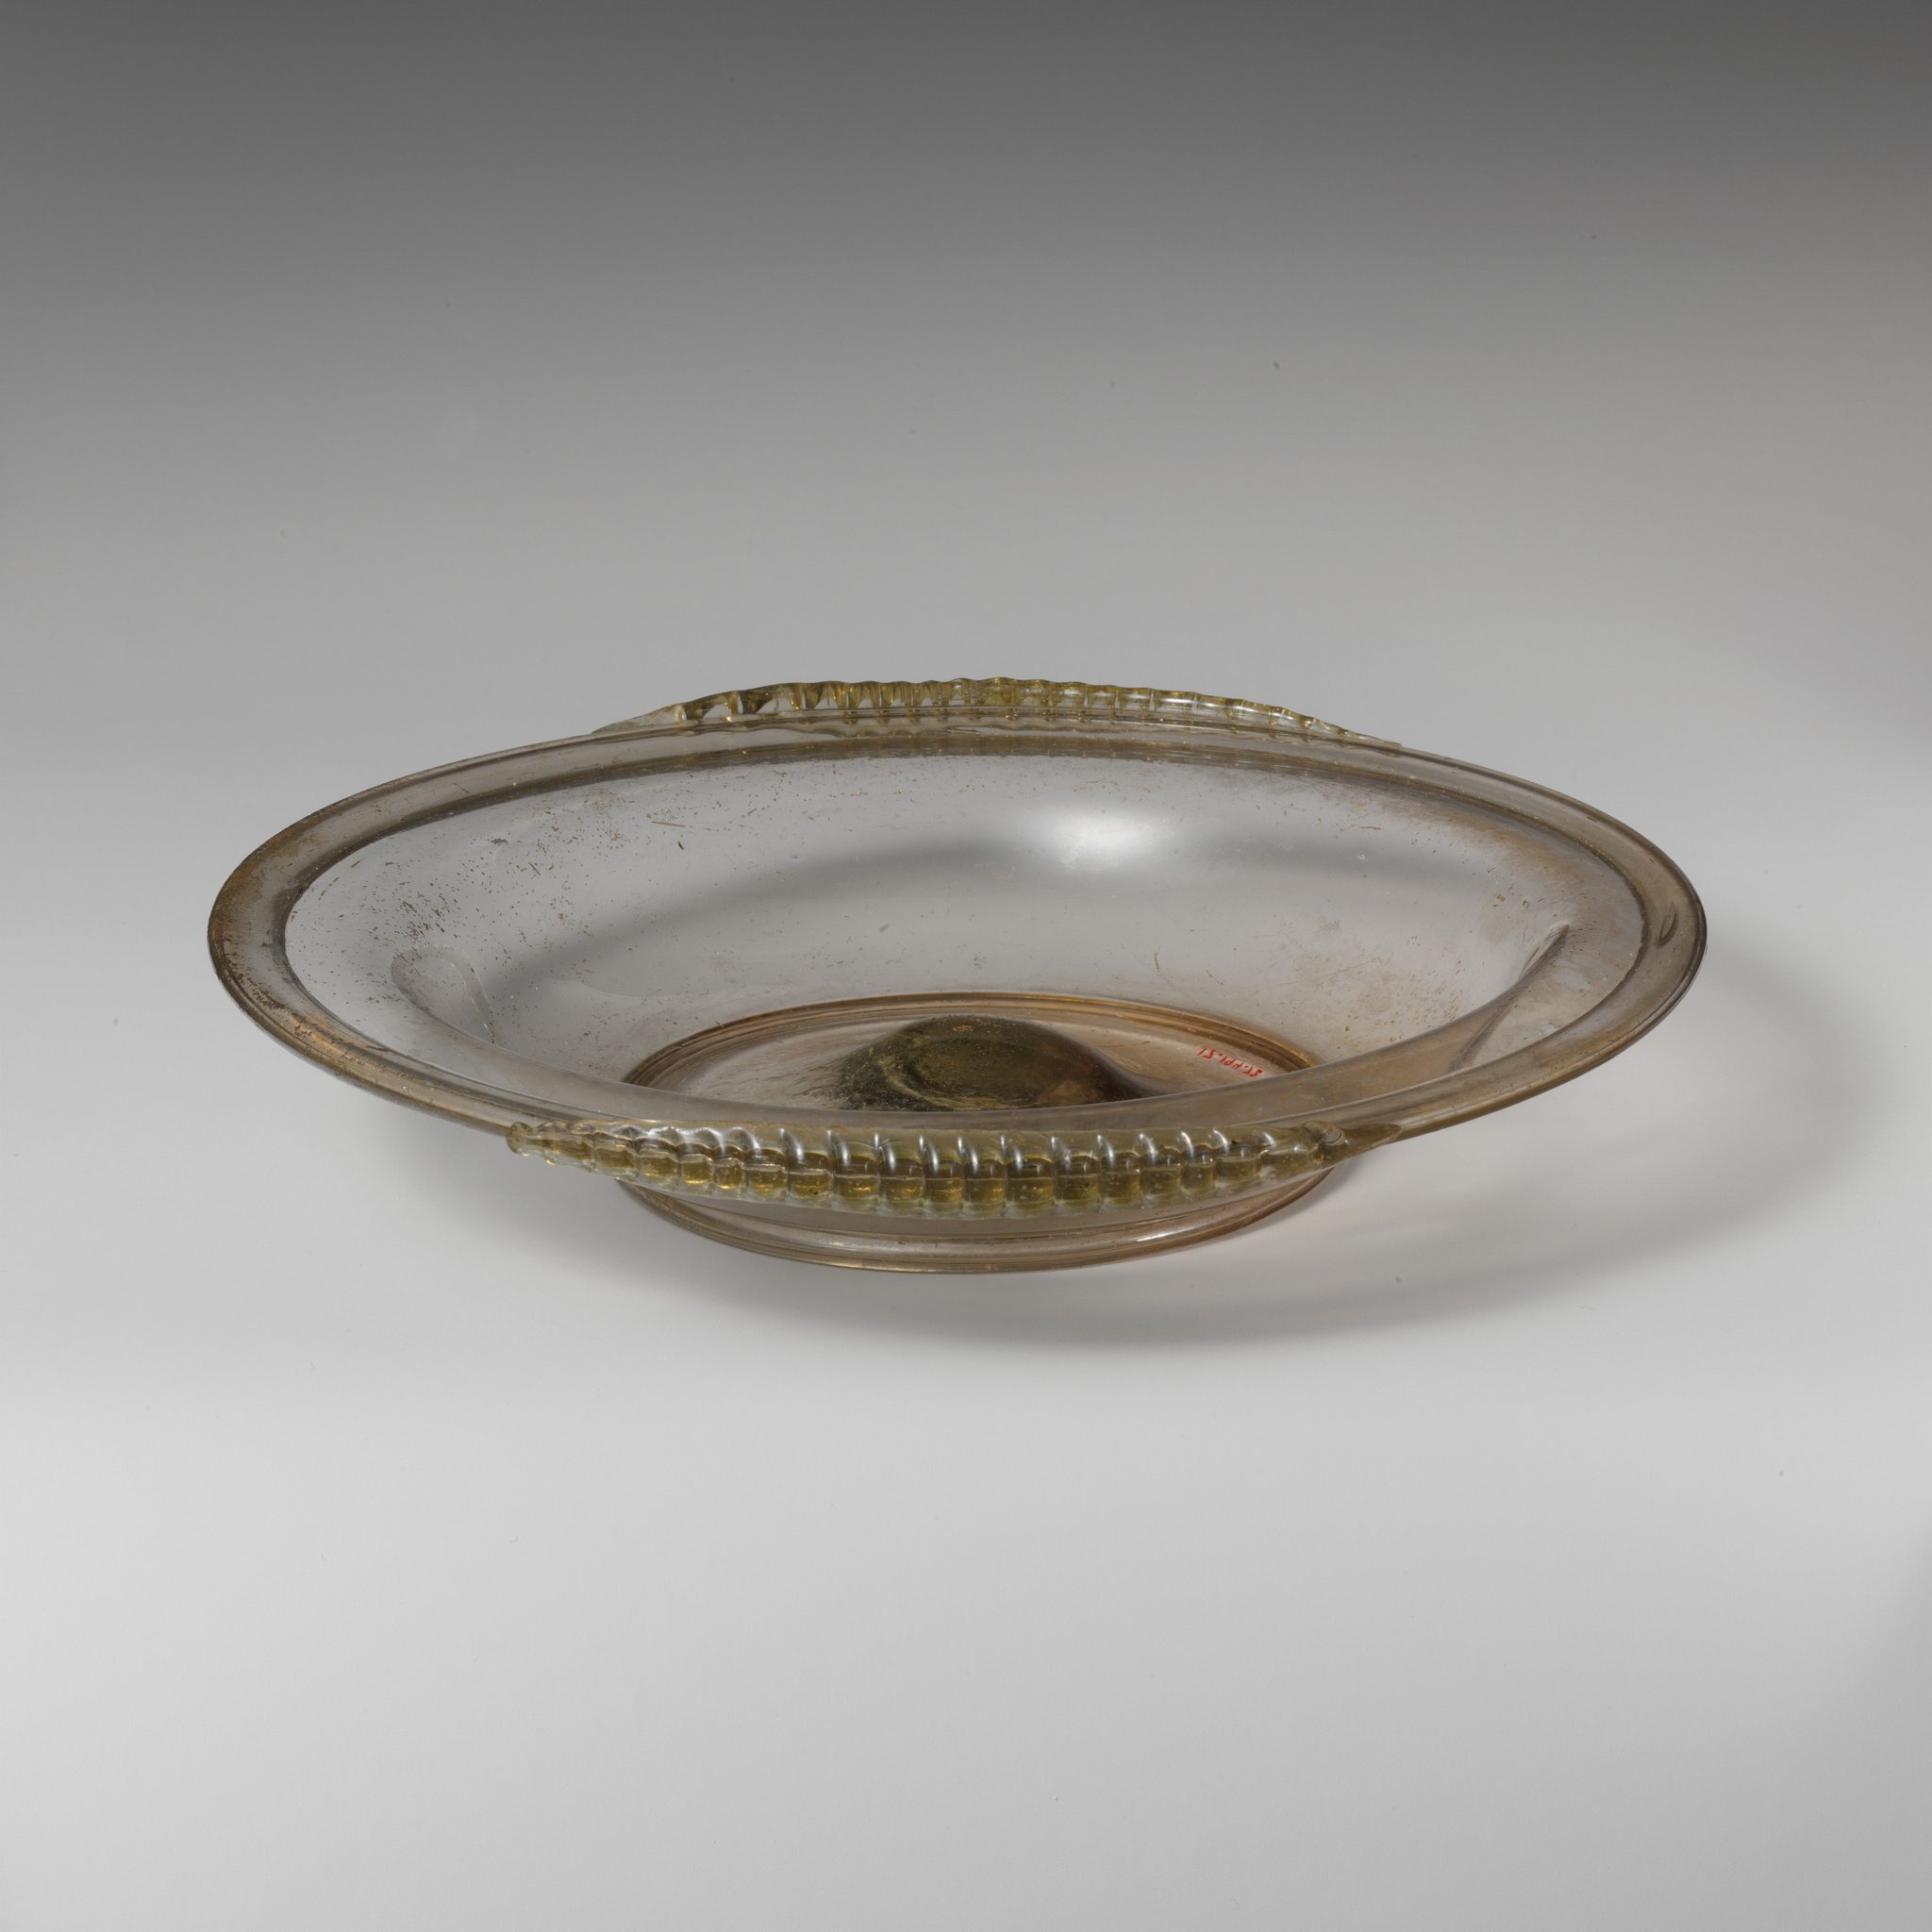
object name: dish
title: Glass dish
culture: roman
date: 67-233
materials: glass